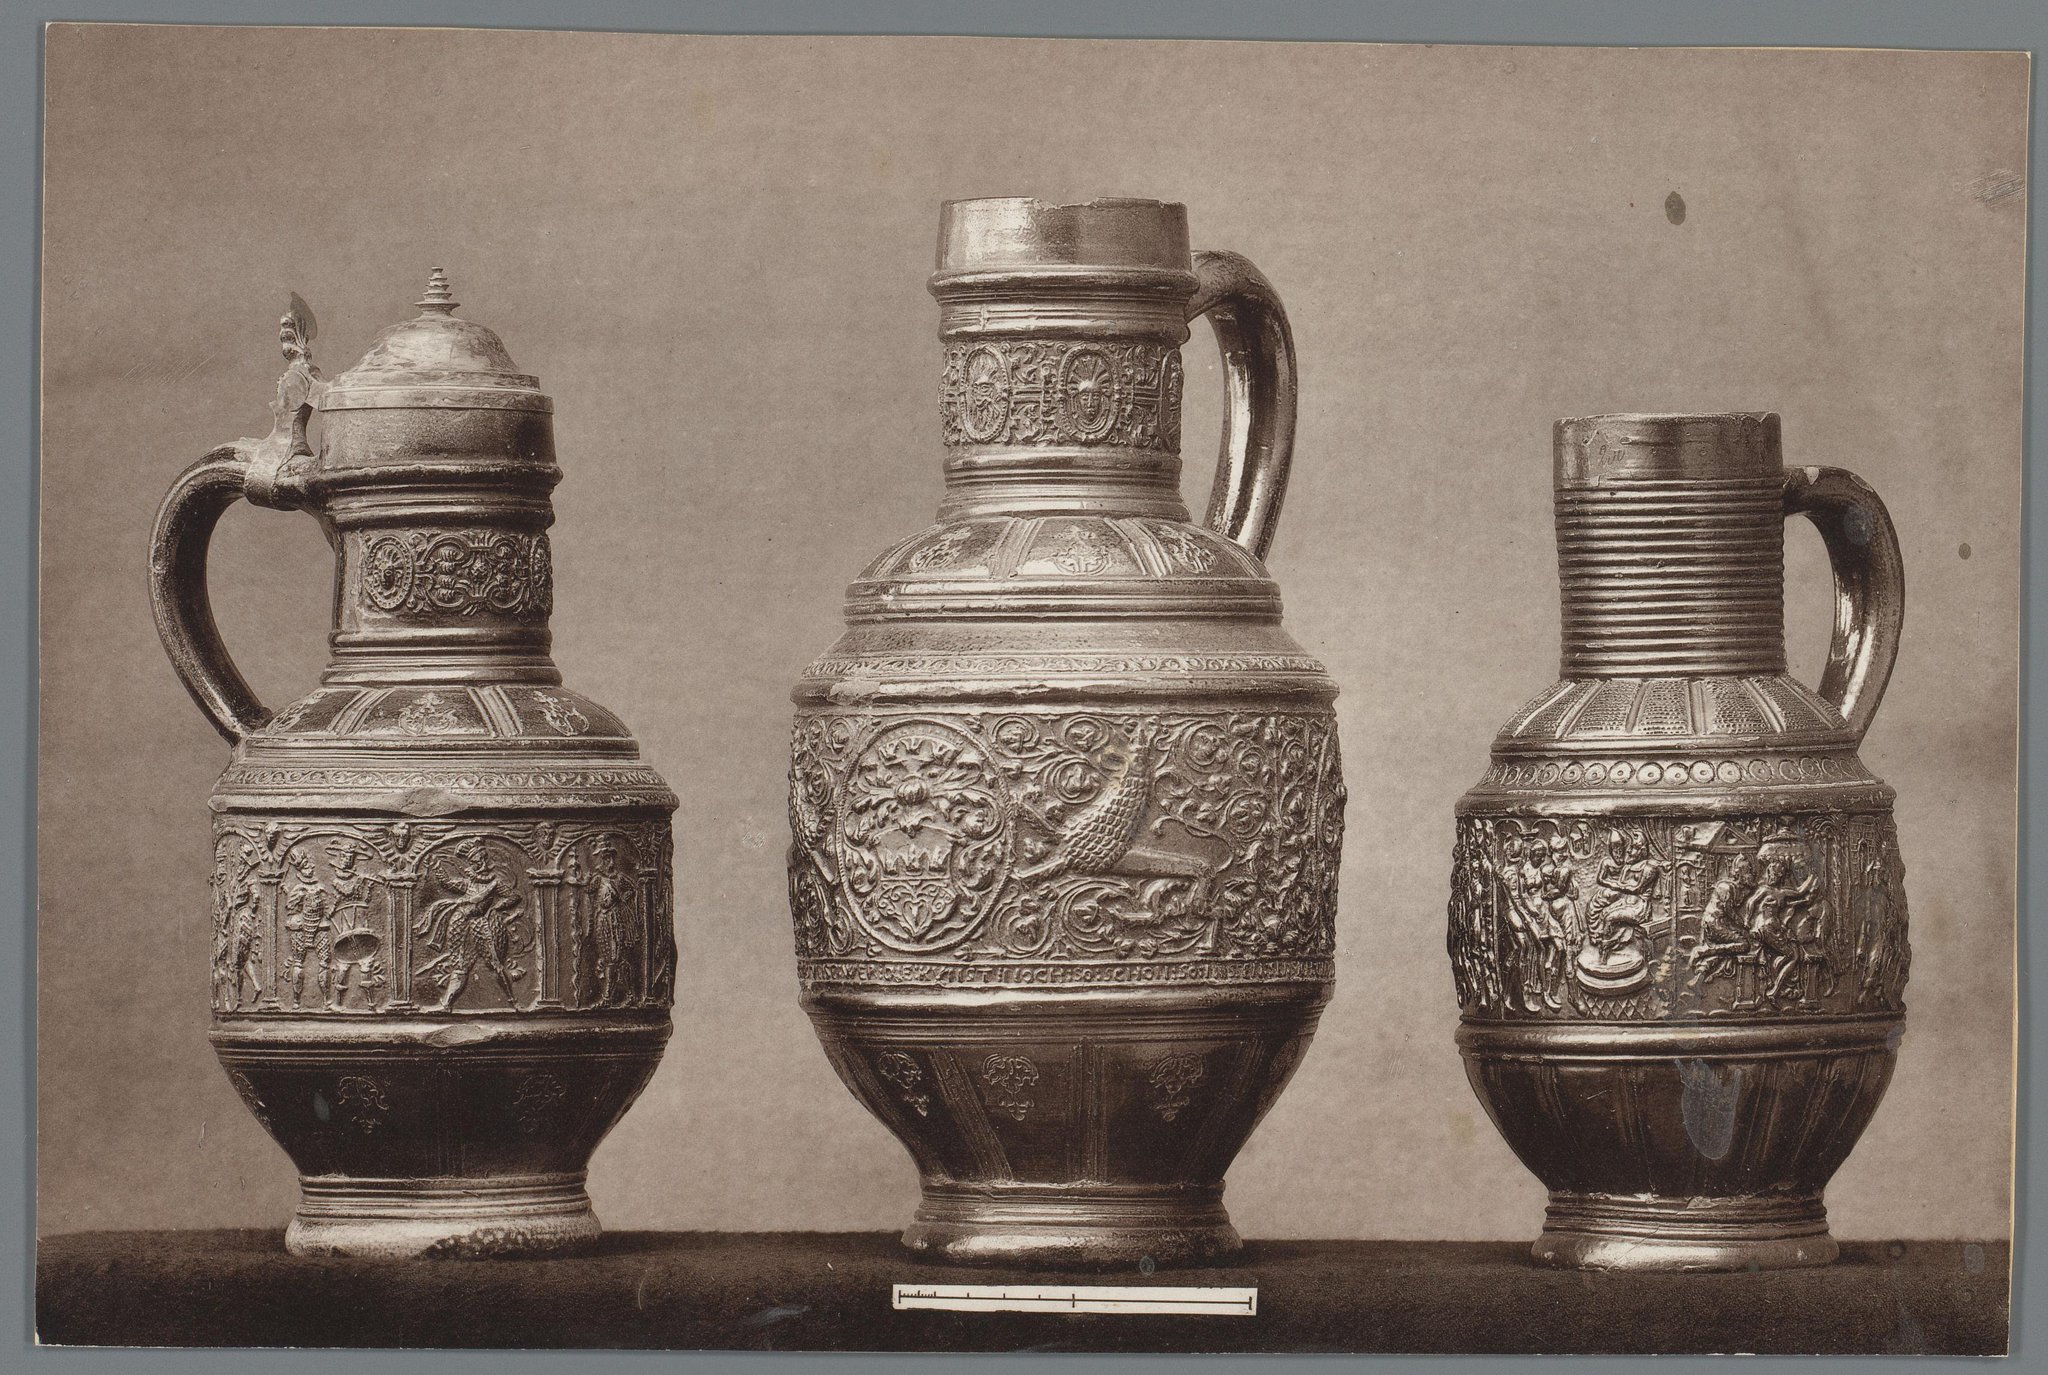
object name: photomechanical print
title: Kölnische Steingutkrüge 1560-1610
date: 1869-1887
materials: cardboard, paper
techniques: photograph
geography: munich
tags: jar, jug (used as drinking-vessel), container of ceramics: jar, jug, pot, vase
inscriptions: collector's mark: Lugt 3937, inscription: ‘Blatt 130.’